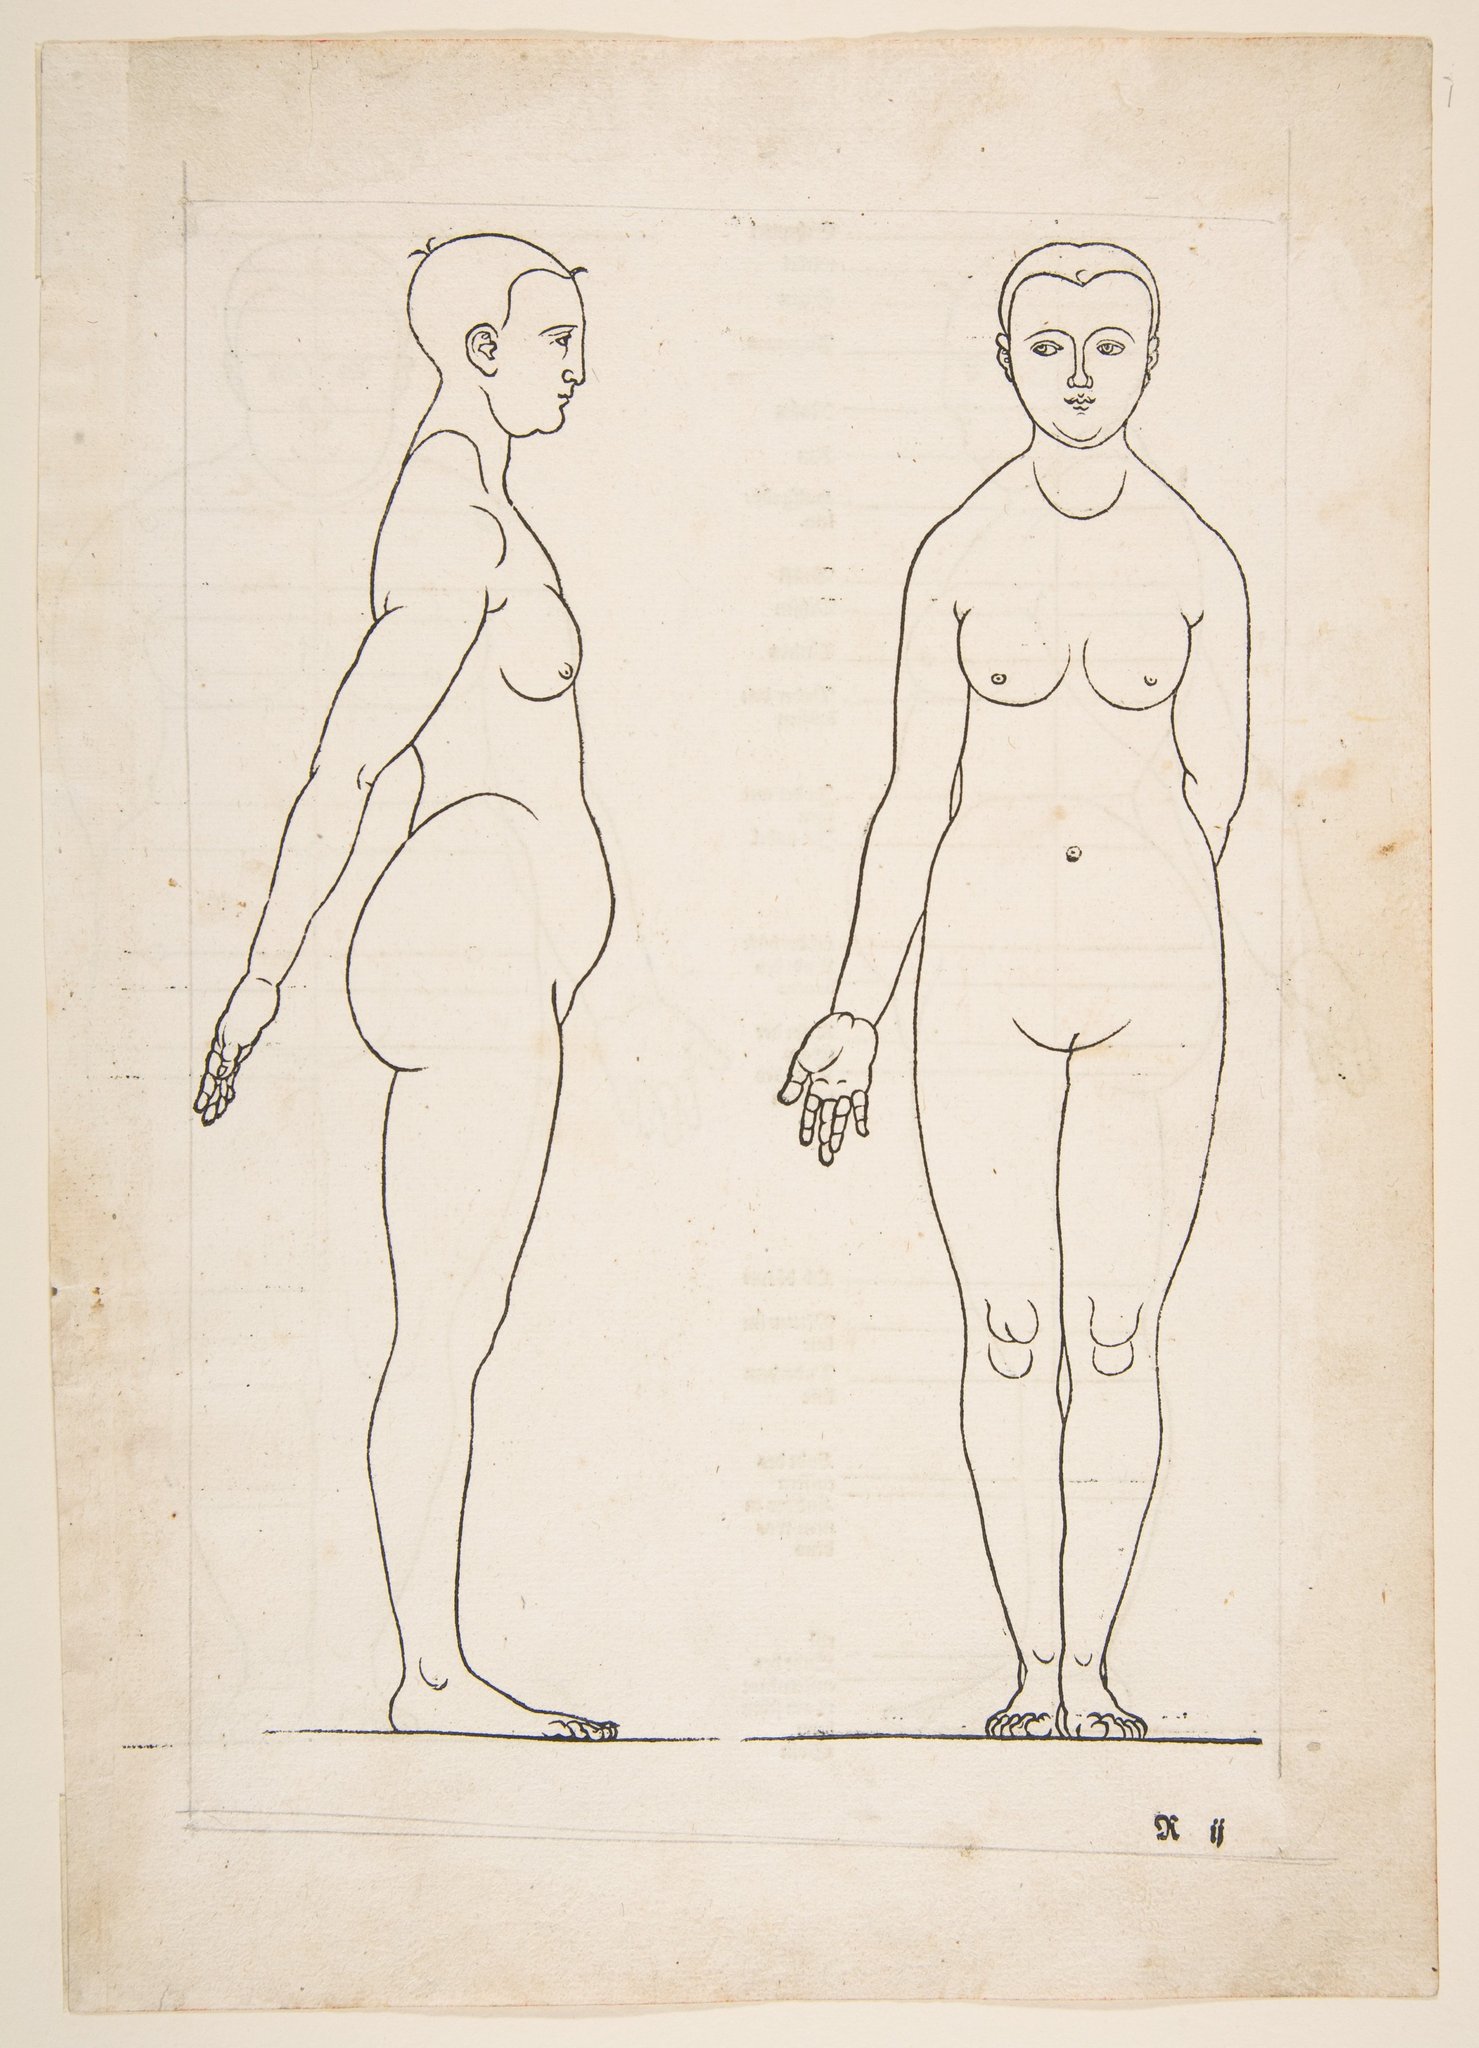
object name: print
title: IIllustration from Dürer's "Vier Bucher von Menslicher Proportion"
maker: albrecht dürer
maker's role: artist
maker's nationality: german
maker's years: 1471-1528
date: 1528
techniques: woodcut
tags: female nudes